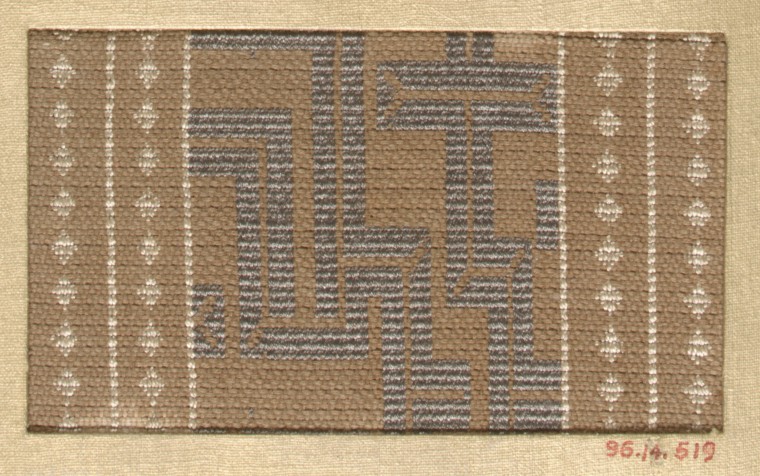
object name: piece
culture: japanese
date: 1701-1900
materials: silk